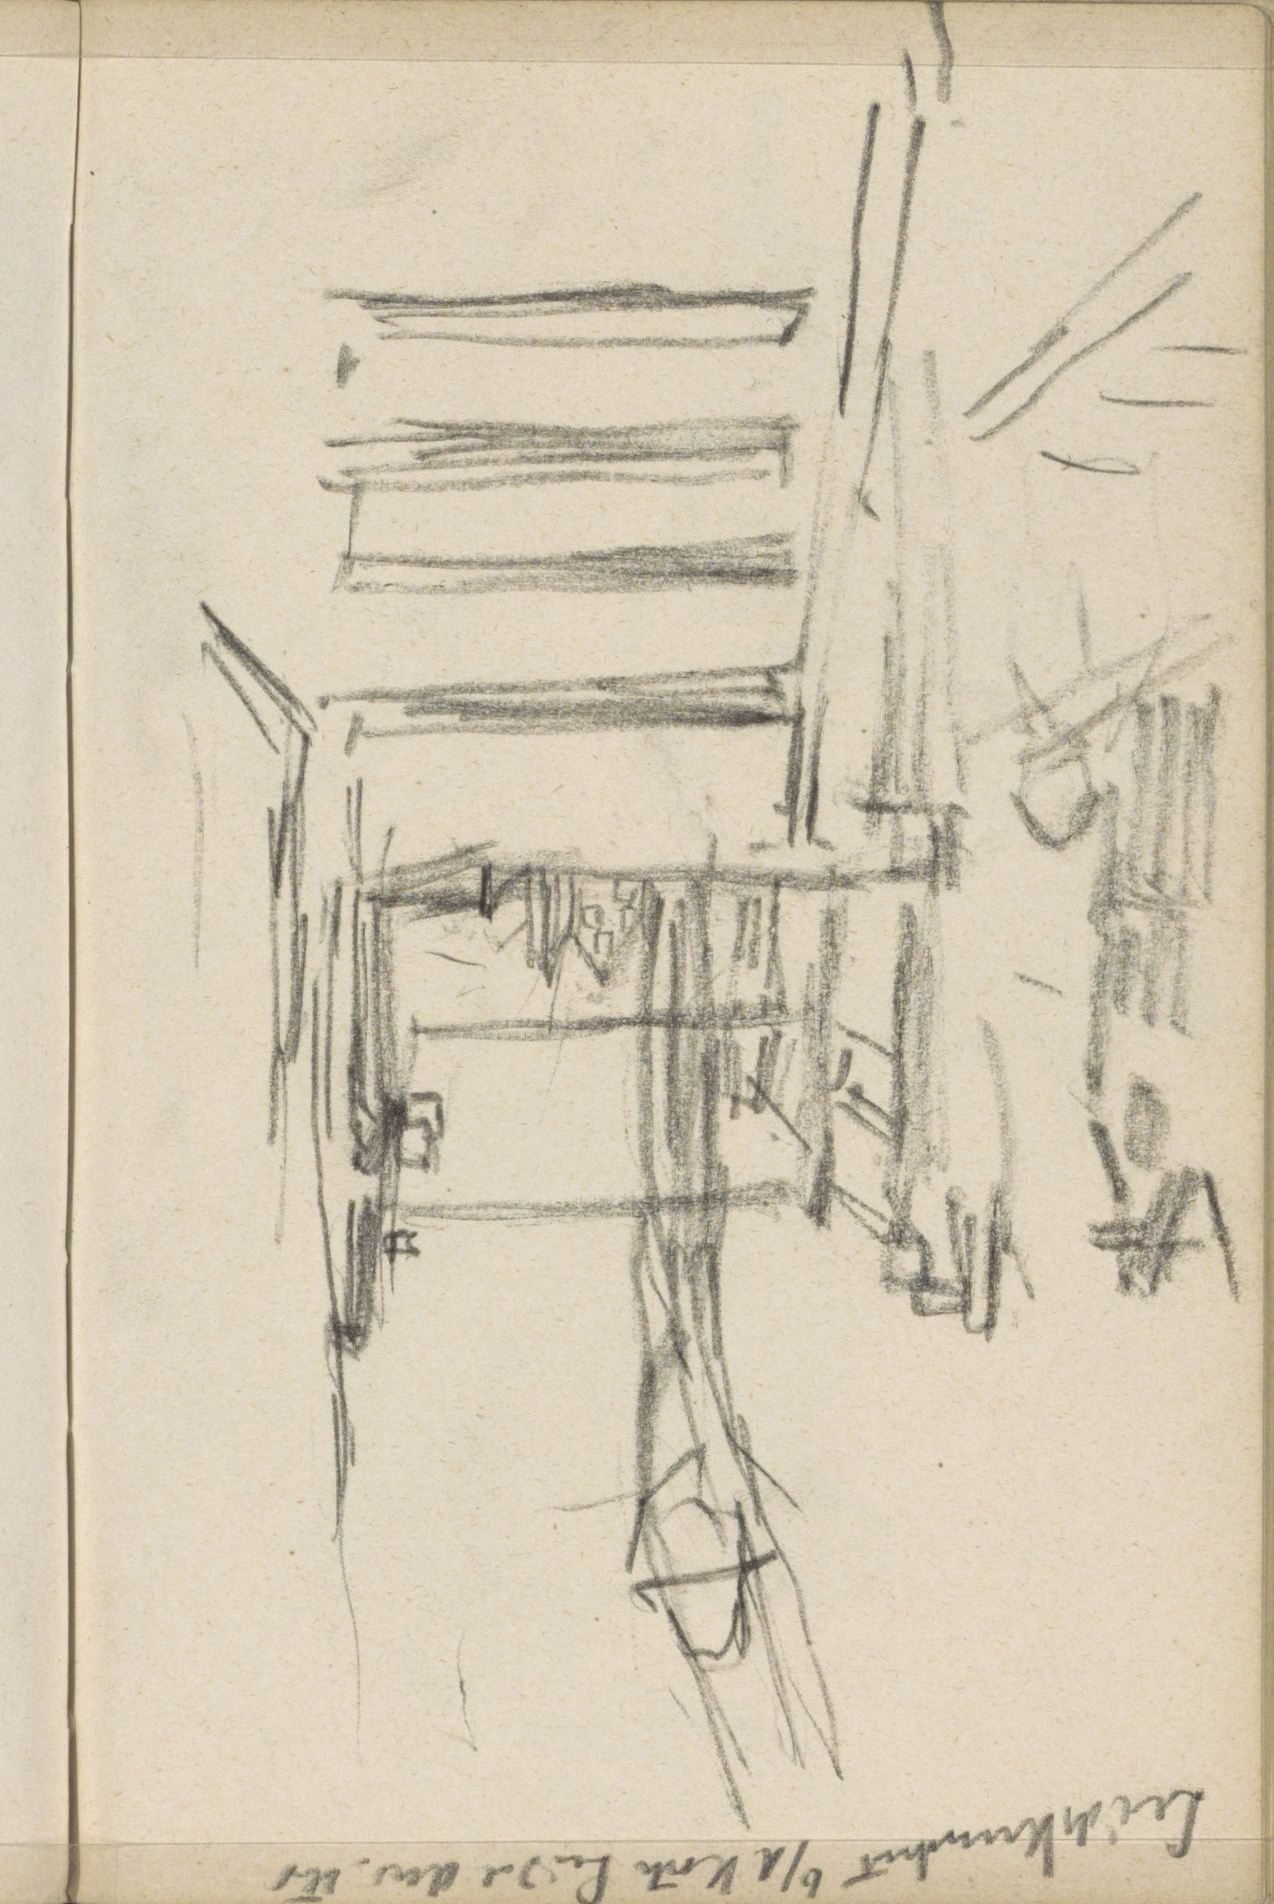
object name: sketchbook leaf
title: Gezicht op een bordes in de Leidsekruisstraat te Amsterdam, ter hoogte van de Korte Leidsedwarsstraat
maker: george hendrik breitner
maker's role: draughtsman, painter, print maker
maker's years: 1857-1923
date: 1907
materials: chalk, paper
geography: amsterdam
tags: urban housing, street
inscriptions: annotation: ‘Leidskruisstraat [sic] b/d Korte Leidsedw. str’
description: Gezicht op een stoep met een bordes in de Leidsekruisstraat te Amsterdam, ter hoogte van de Korte Leidsedwarsstraat. Pagina 64 uit een schetsboek met 46 bladen vervaardigd in Amsterdam, Rotterdam en Haarlem.